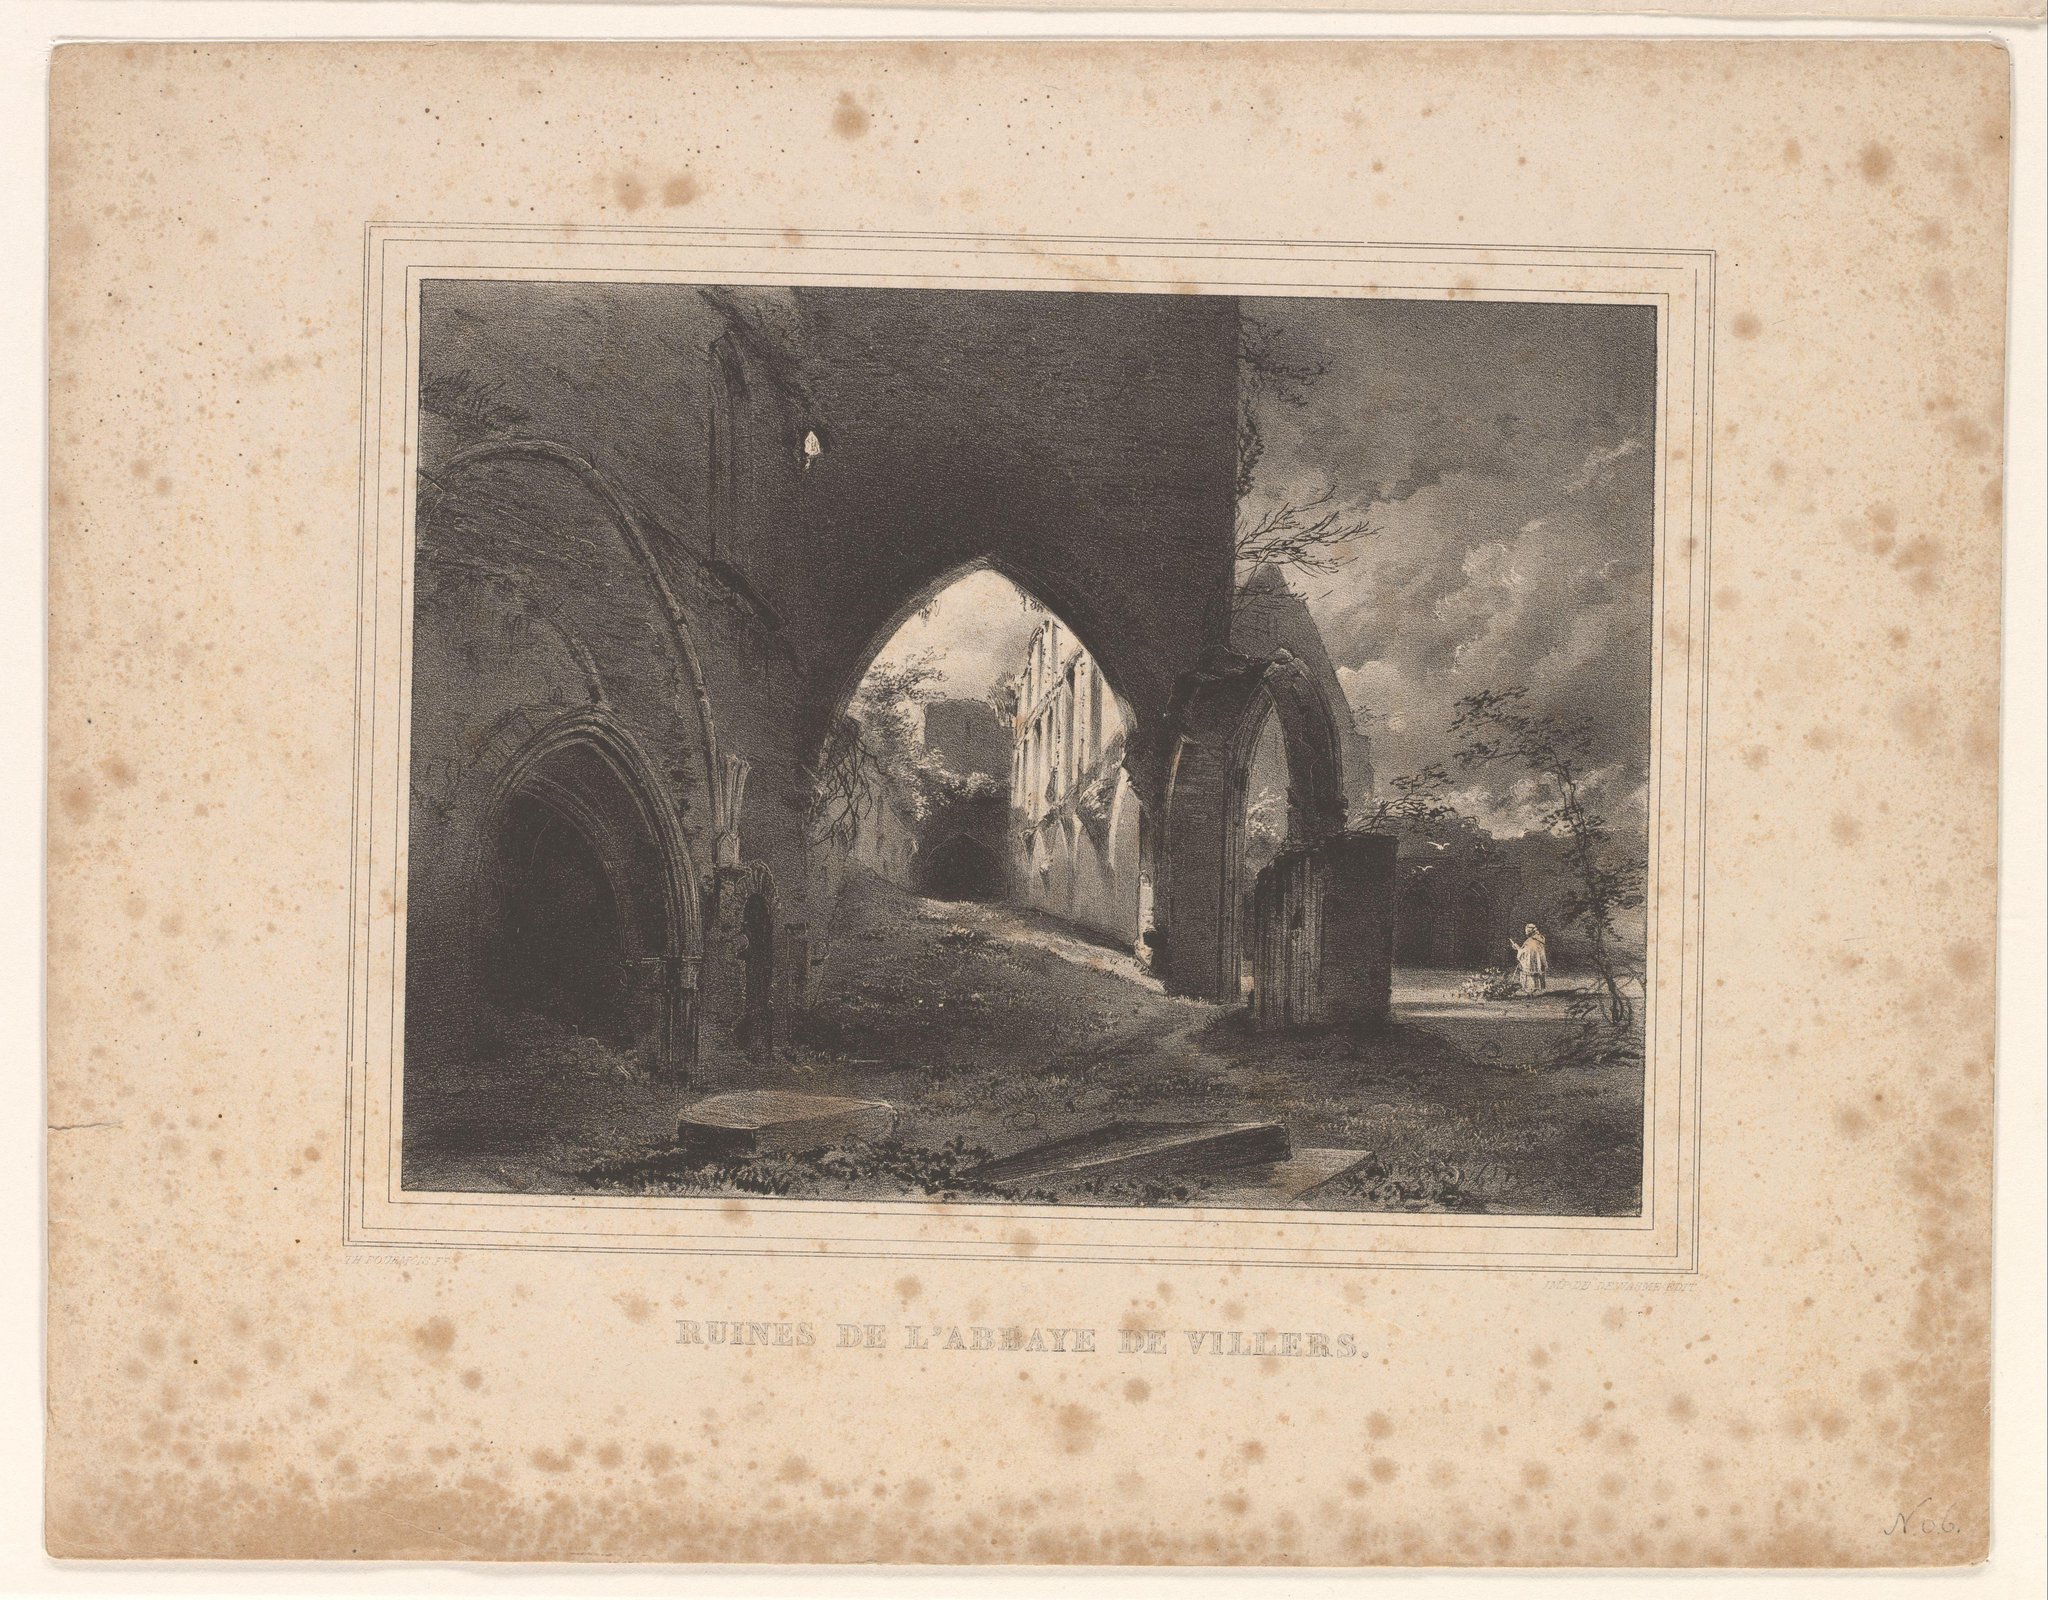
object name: print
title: Gezichten op de omgeving van Brussel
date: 1825-1827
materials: paper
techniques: lithograph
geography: brussels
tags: abbey, monastery, convent ~ roman catholic church, landscape with ruins, monk(s), friar(s)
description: Prent maakt waarschijnlijk deel uit van een serie met gezichten op de omgeving van Brussel. Over deze serie is verder niets bekend. Het betreft voornamelijk landschappen en gebouwen.